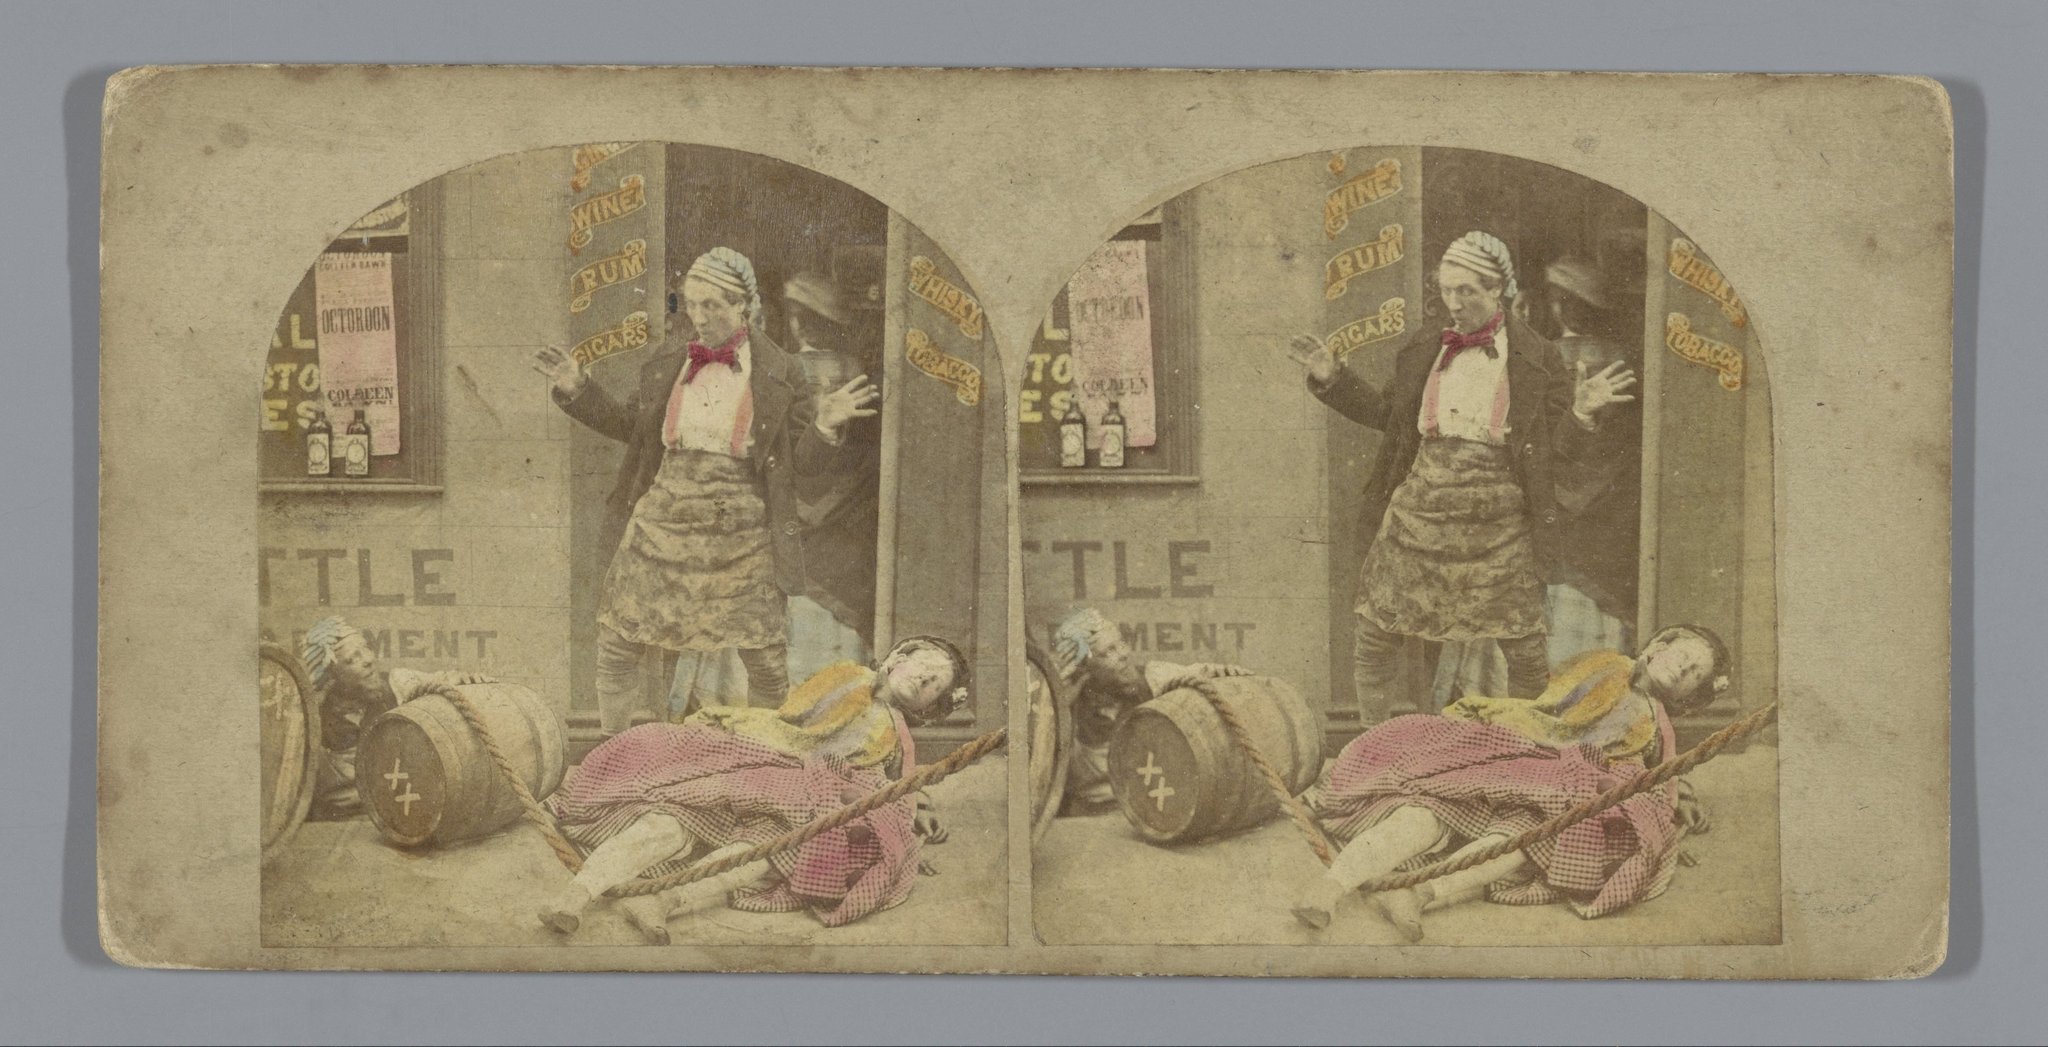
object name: stereograph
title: Straattafereel met een vrouw die over een touw gevallen is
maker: Anonymous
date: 1852-1863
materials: cardboard, paper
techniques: albumen print, hand coloring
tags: falling, comedy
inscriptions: number: ‘2,50’, number: ‘8’